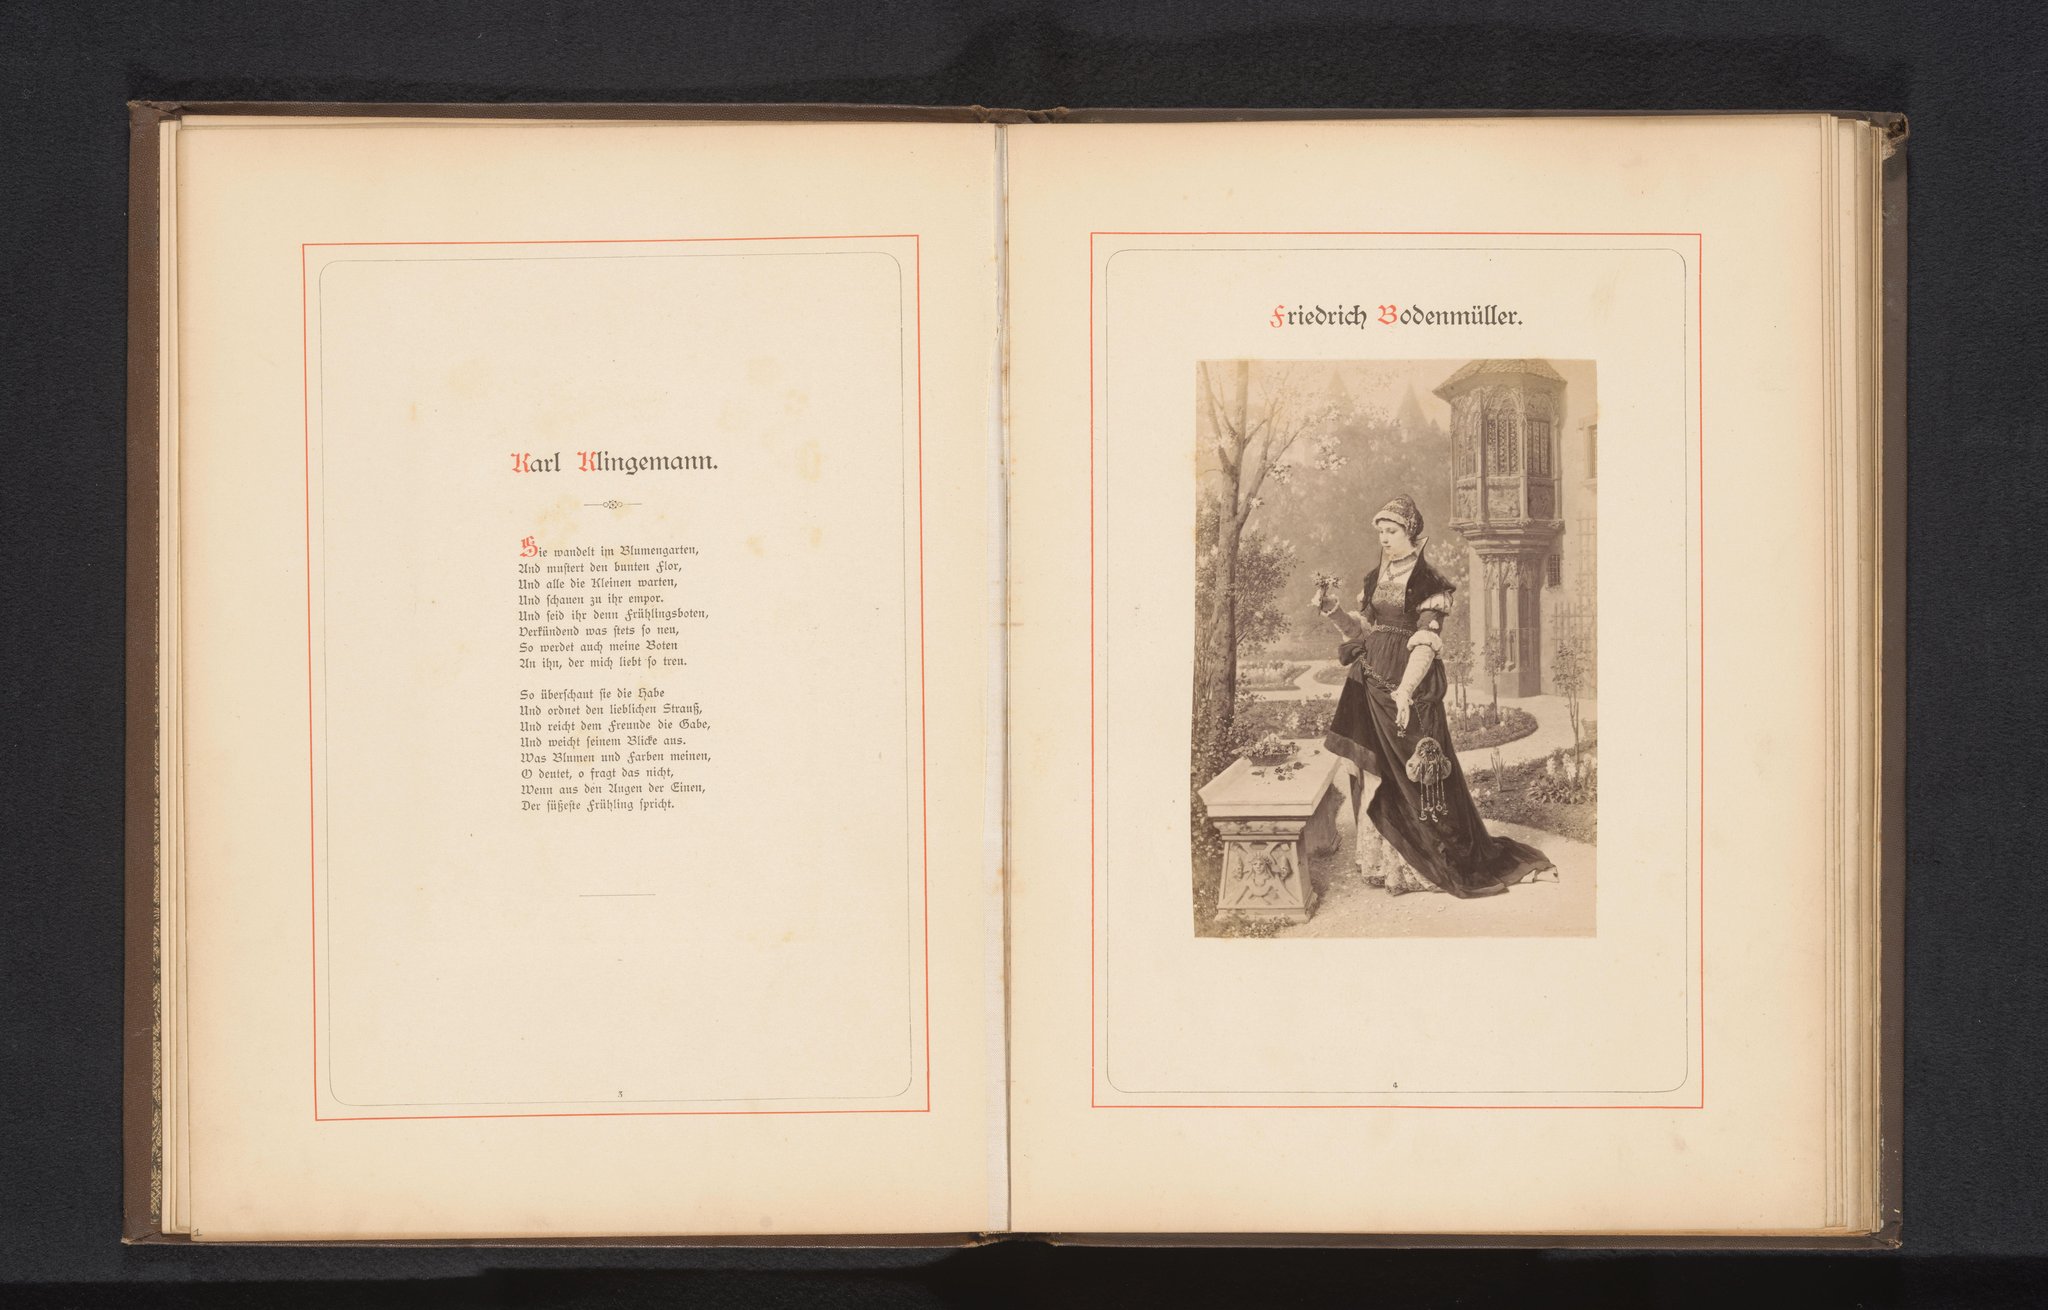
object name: photograph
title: Friedrich Bodenmüller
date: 1875-1885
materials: photographic support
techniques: albumen print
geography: munich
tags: adolescent, young woman, maiden, cut flowers; nosegay, bunch of flowers, picture, painting